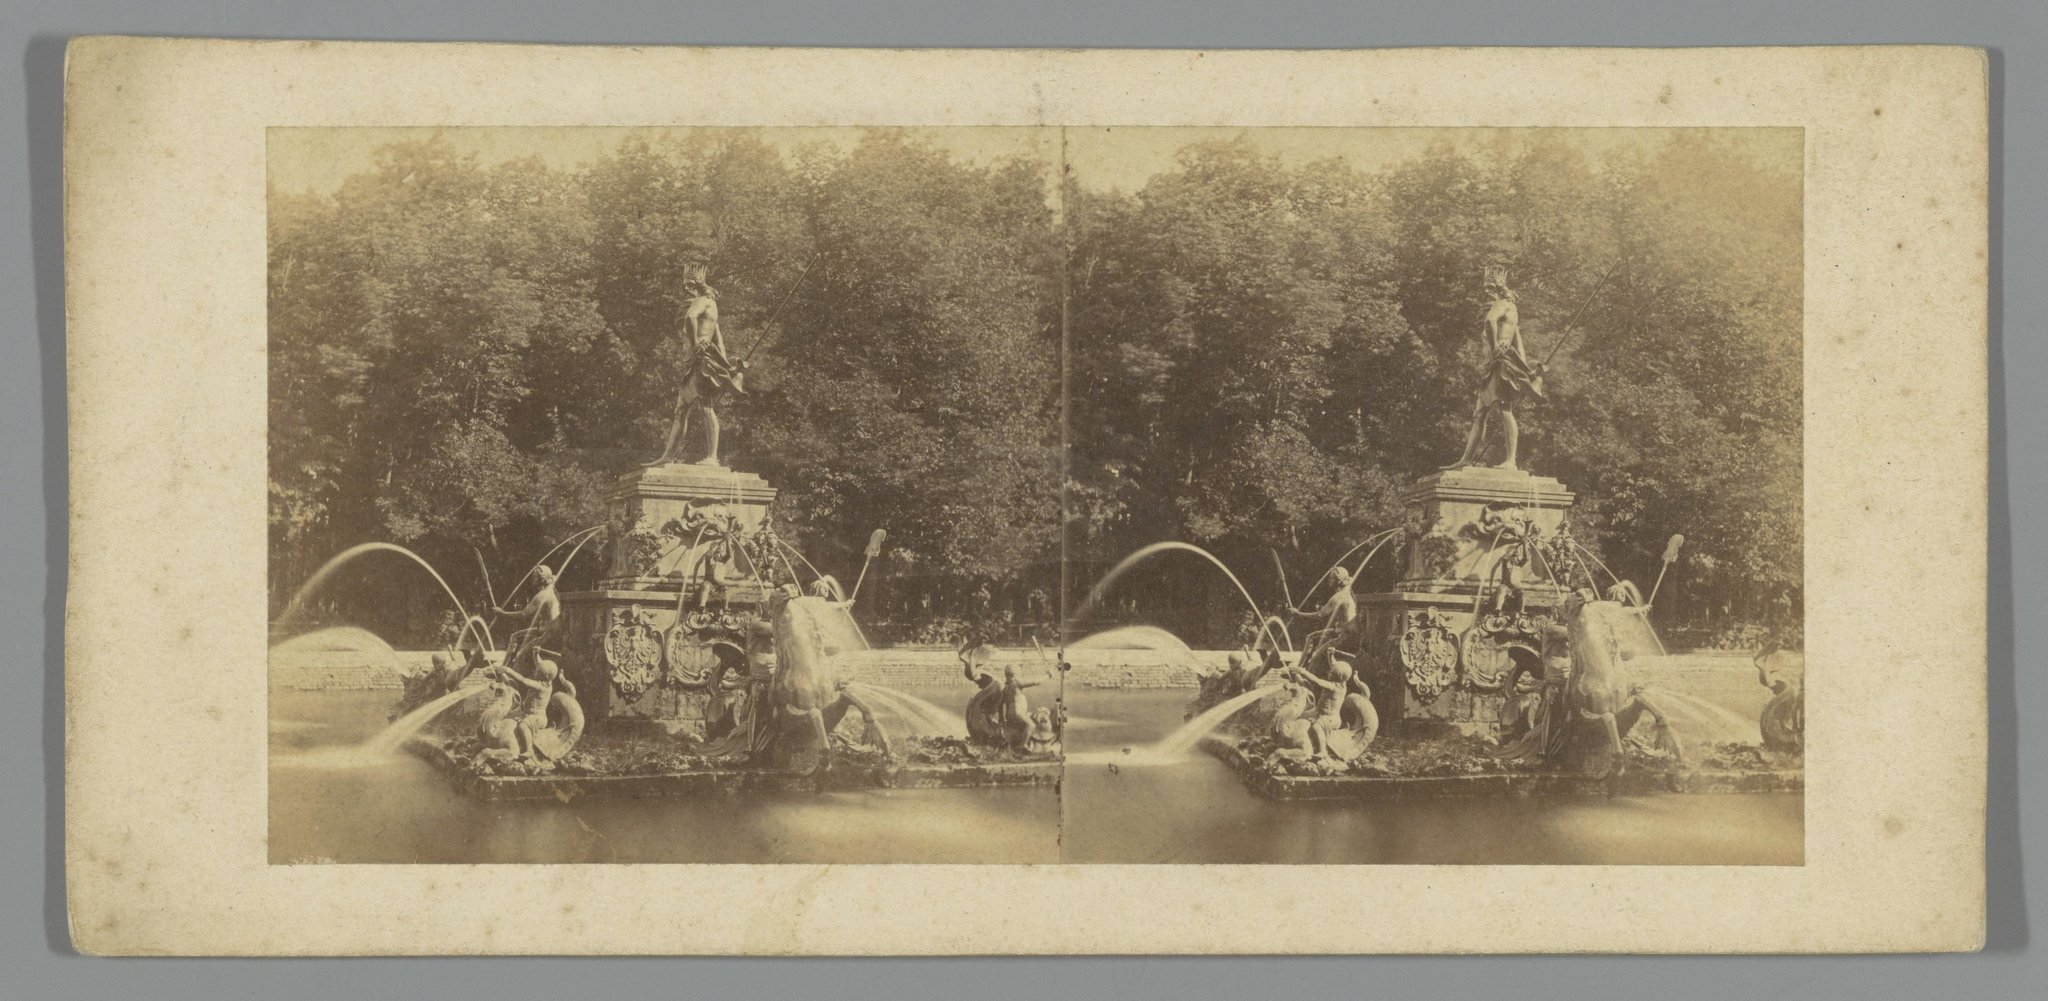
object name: stereograph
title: Fontein in een vijver (vermoedelijk) te Duitsland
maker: Anonymous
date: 1855-1870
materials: cardboard, photographic support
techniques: albumen print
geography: germany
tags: ornamental fountain, garden pond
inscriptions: inscription: ‘Garten in Pekhoff’